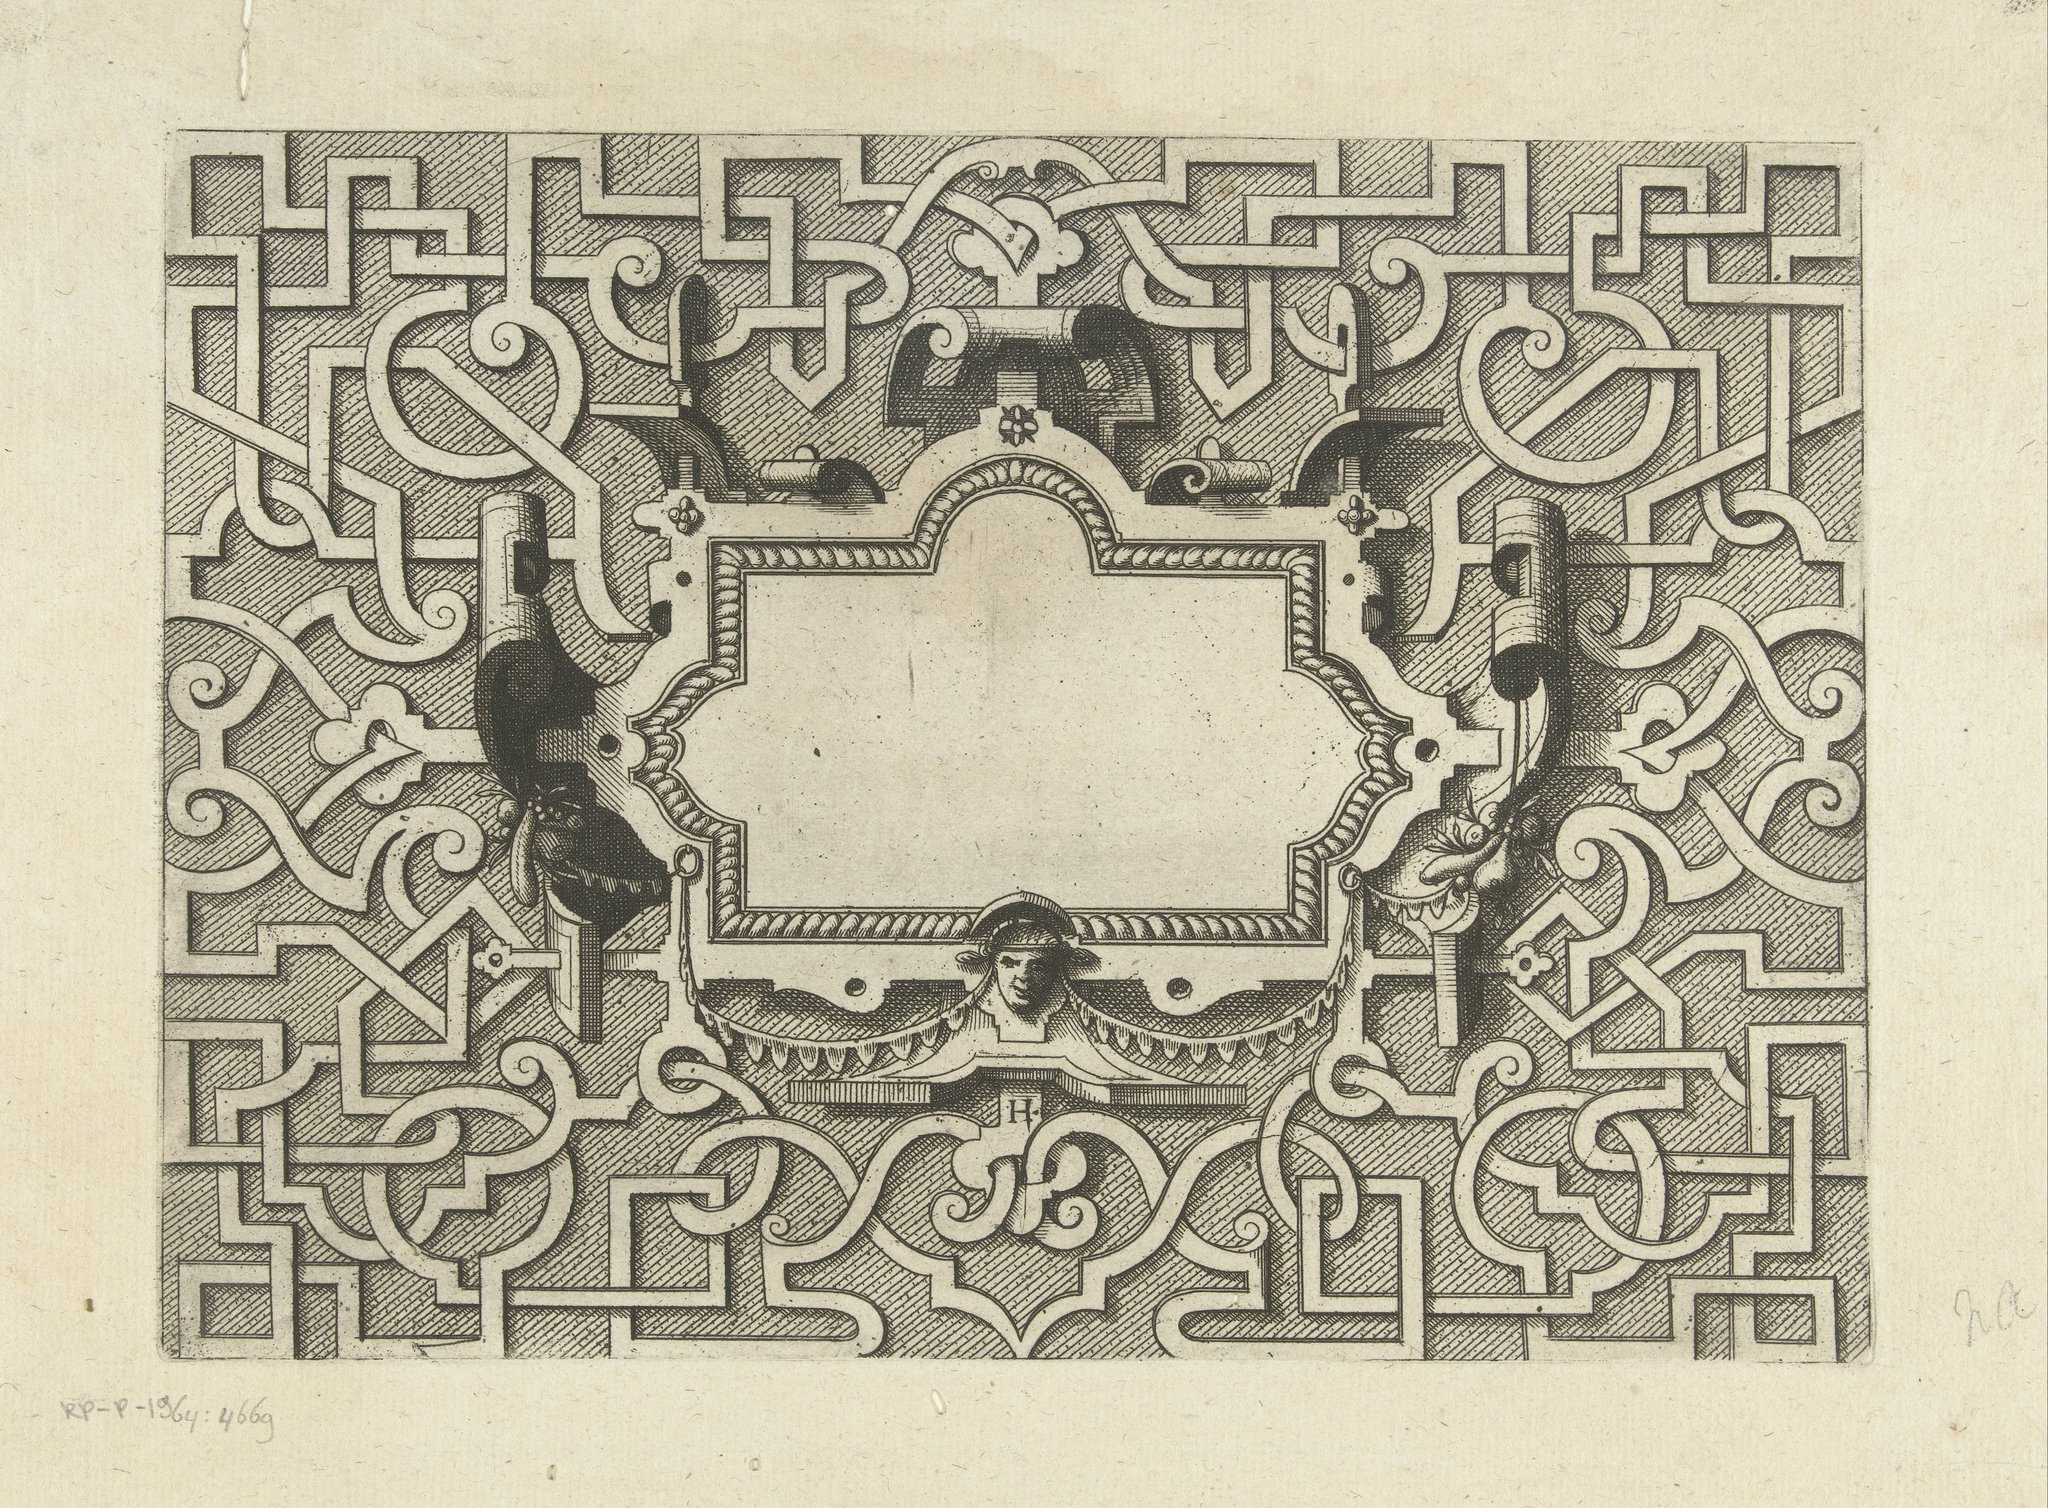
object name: print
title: Cartouche met een koordrand, omgeven door moresken.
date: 1555-1560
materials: paper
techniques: etching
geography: netherlands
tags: ornament ~ moresque, ornament ~ cartouche, mask, mascaron ~ ornament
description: Op de onderrand van de cartouche zit een mascaron. Blad H uit serie van 16 bladen, geletterd A-Q. Gearceerde of gestippelde achtergrond.